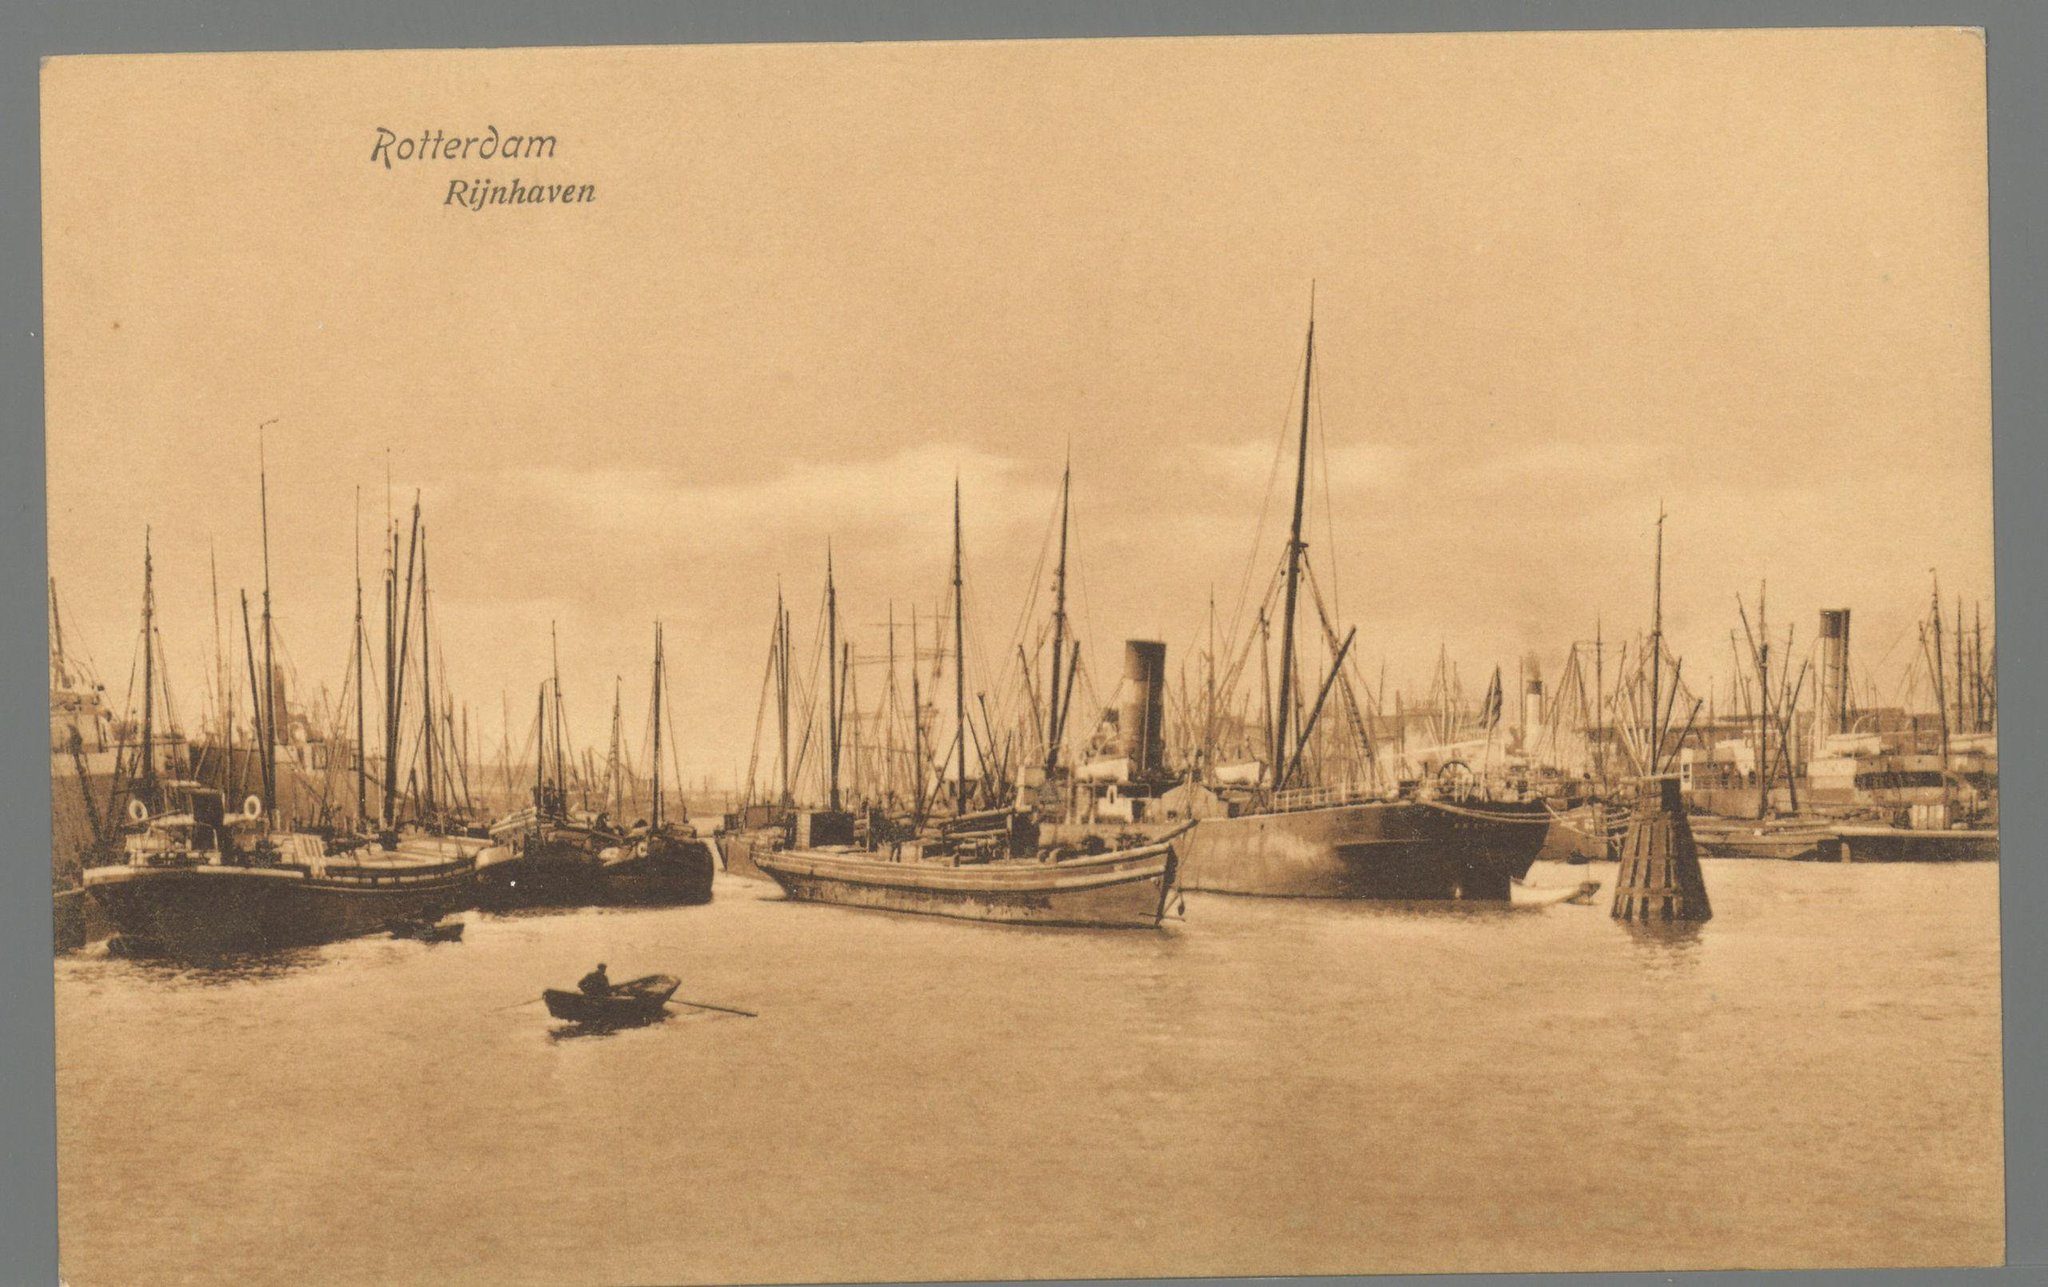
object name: photomechanical print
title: Rotterdam - Rijnhaven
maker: Anonymous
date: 1910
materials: cardboard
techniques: photograph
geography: the hague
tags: harbour, sailing-ship, sailing-boat, steamship, motorship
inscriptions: date